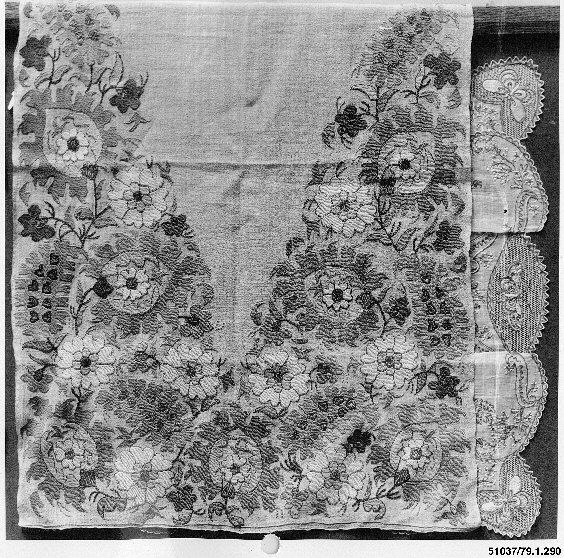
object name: towel end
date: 1801-1833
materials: linen, metal thread, silk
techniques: embroidery, weave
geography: turkey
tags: flowers